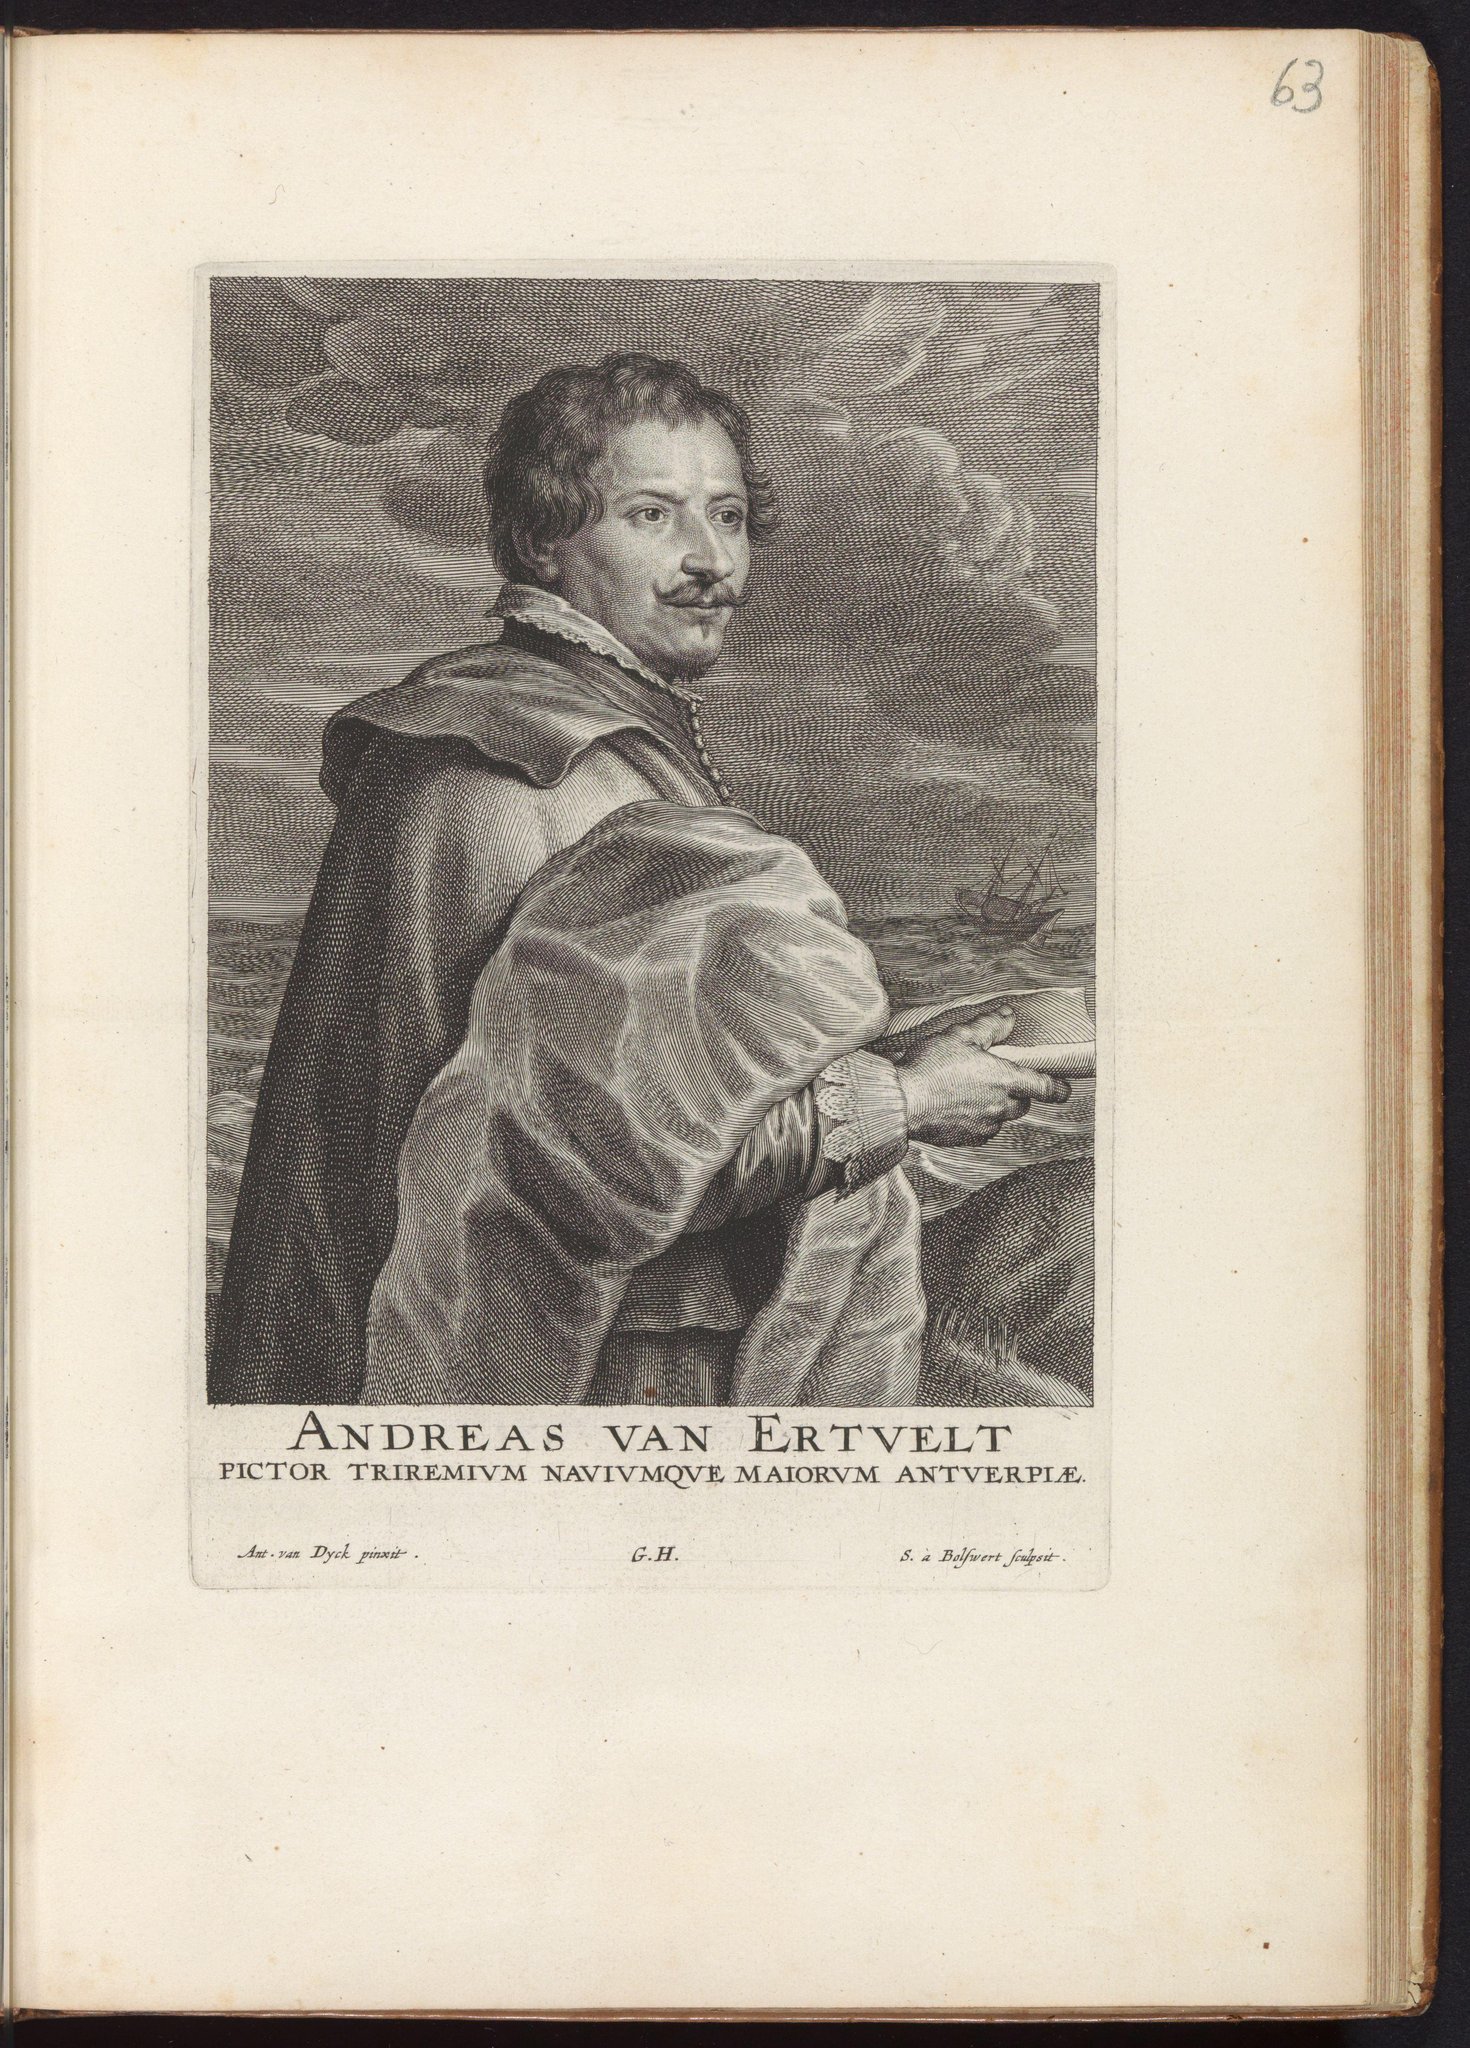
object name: album leaf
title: Portret van schilder Andries van Eertvelt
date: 1630-1641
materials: paper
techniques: engraving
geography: antwerp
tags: antwerp, draughtsman, andries van eertvelt, portrait, self-portrait of painter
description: Deze prent maakt deel uit van een album.